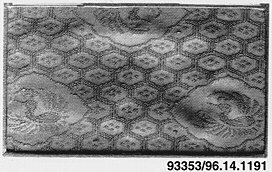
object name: piece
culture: japanese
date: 1701-1900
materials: silk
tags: birds